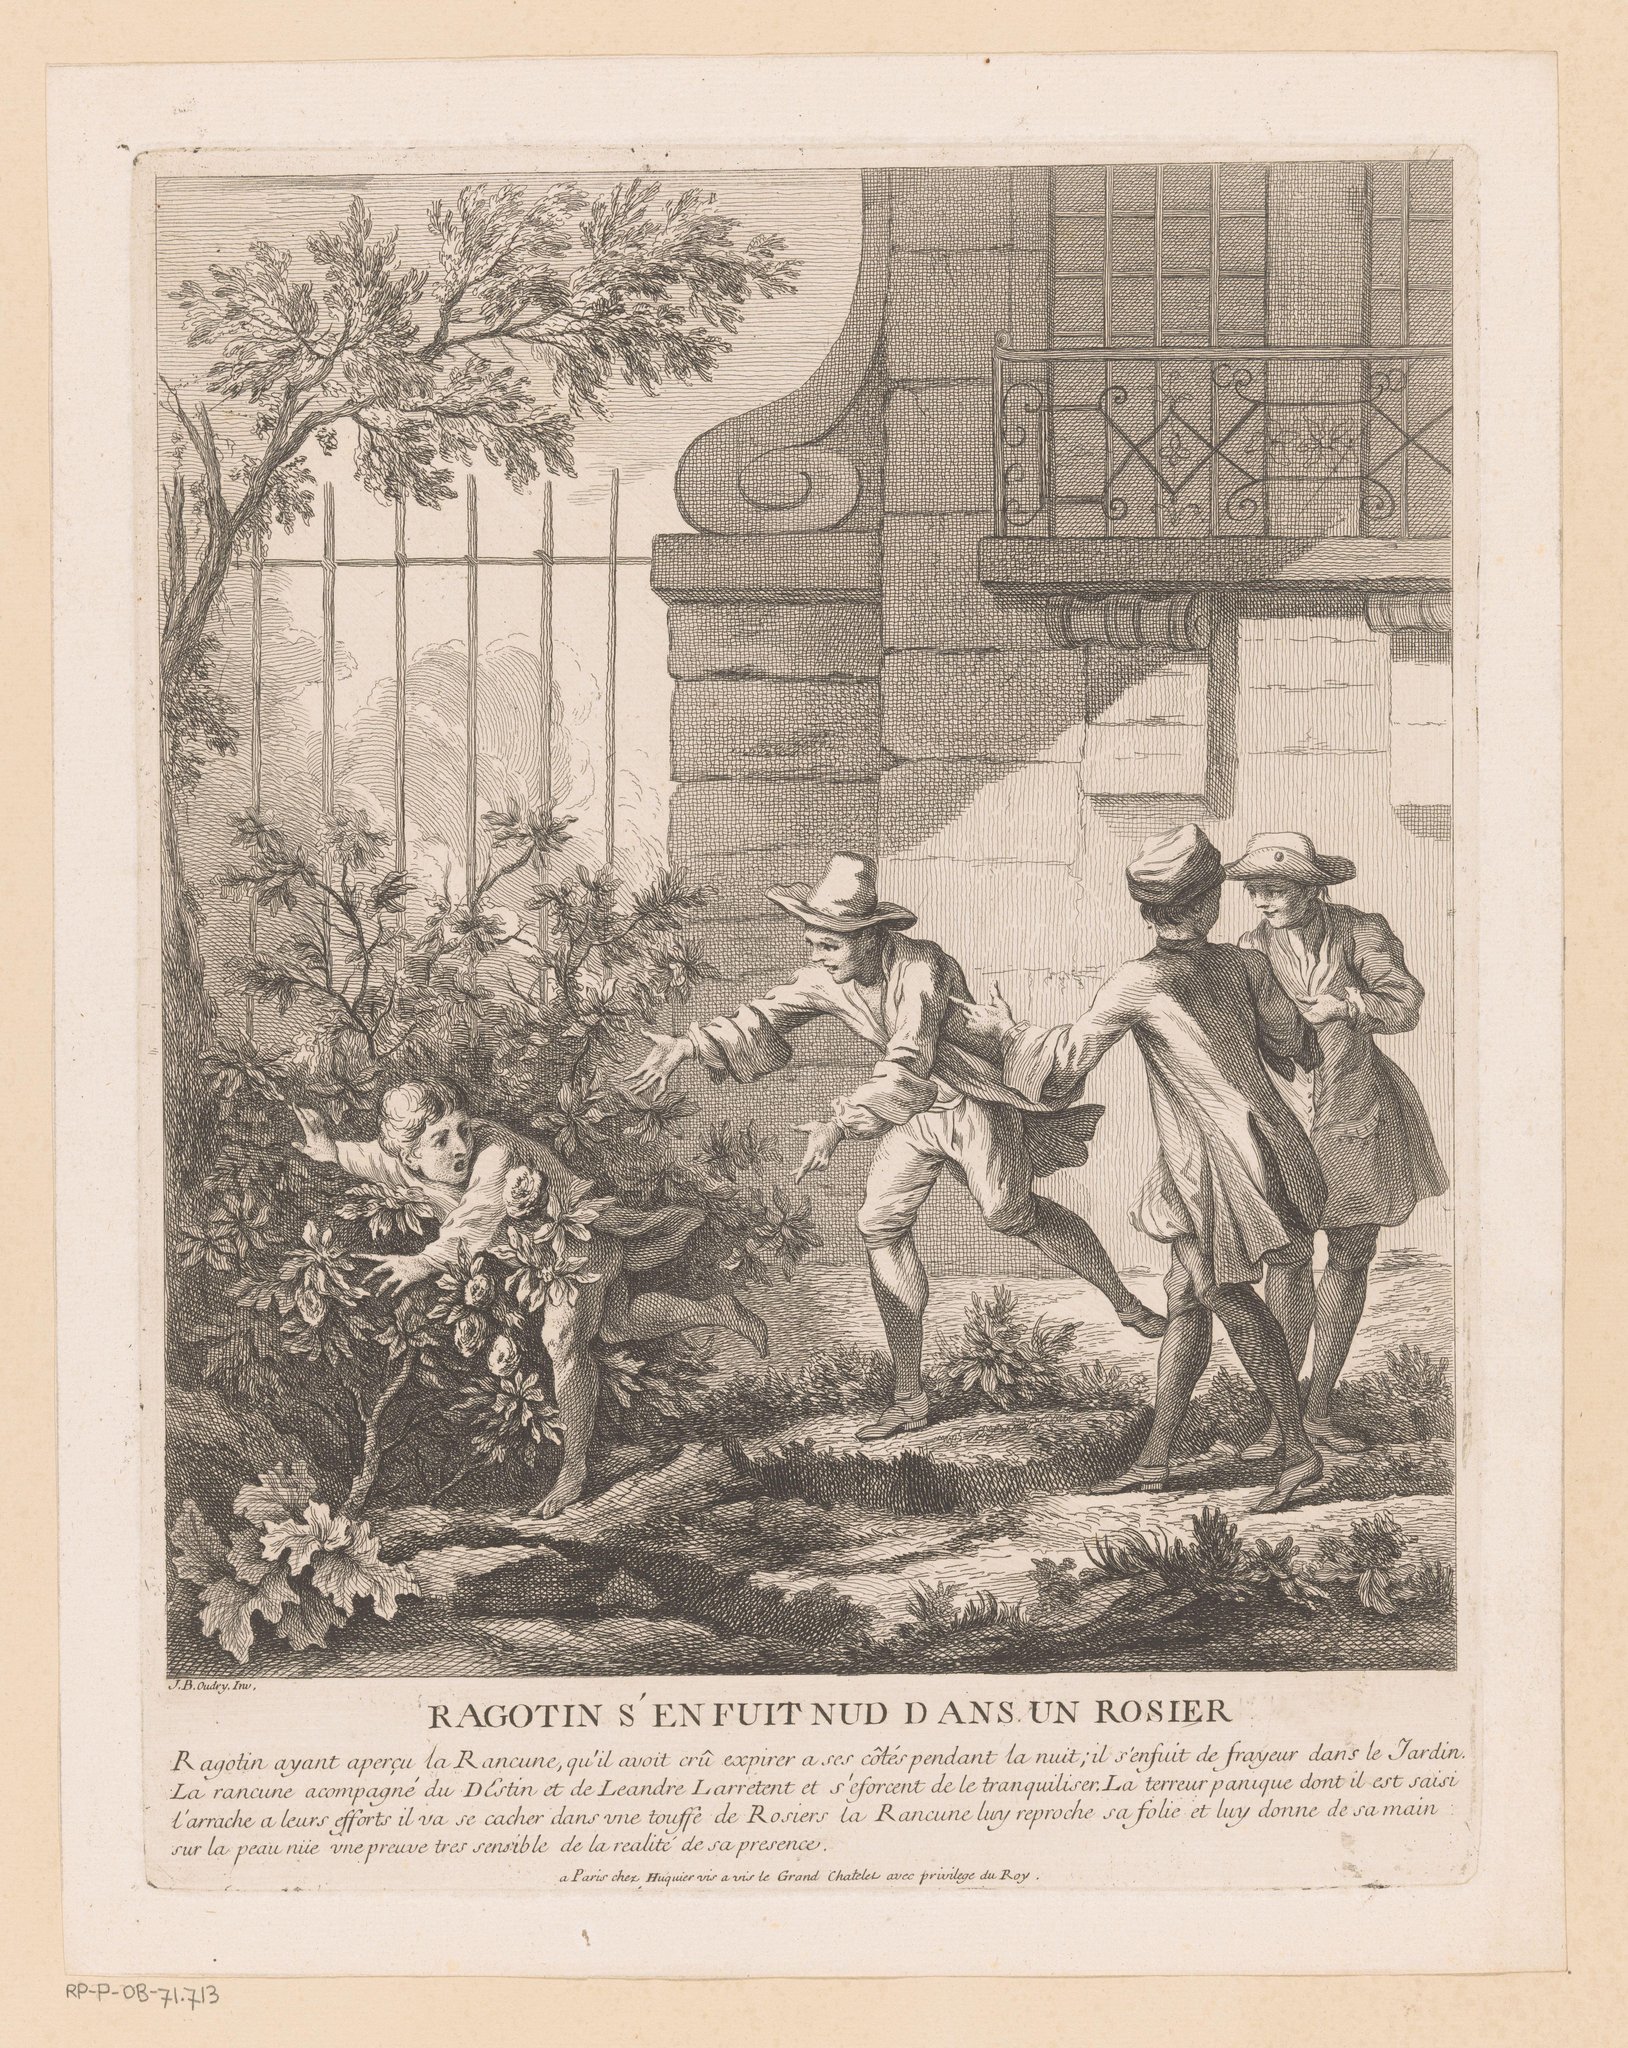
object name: print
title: Ragotin s'en fuit nud dans un rosier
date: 1705-1772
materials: paper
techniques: engraving, etching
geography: paris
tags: (scarron, roman comique) specific works of literature (with author, title), shrubs: rose-bush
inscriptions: collector's mark: Lugt 240